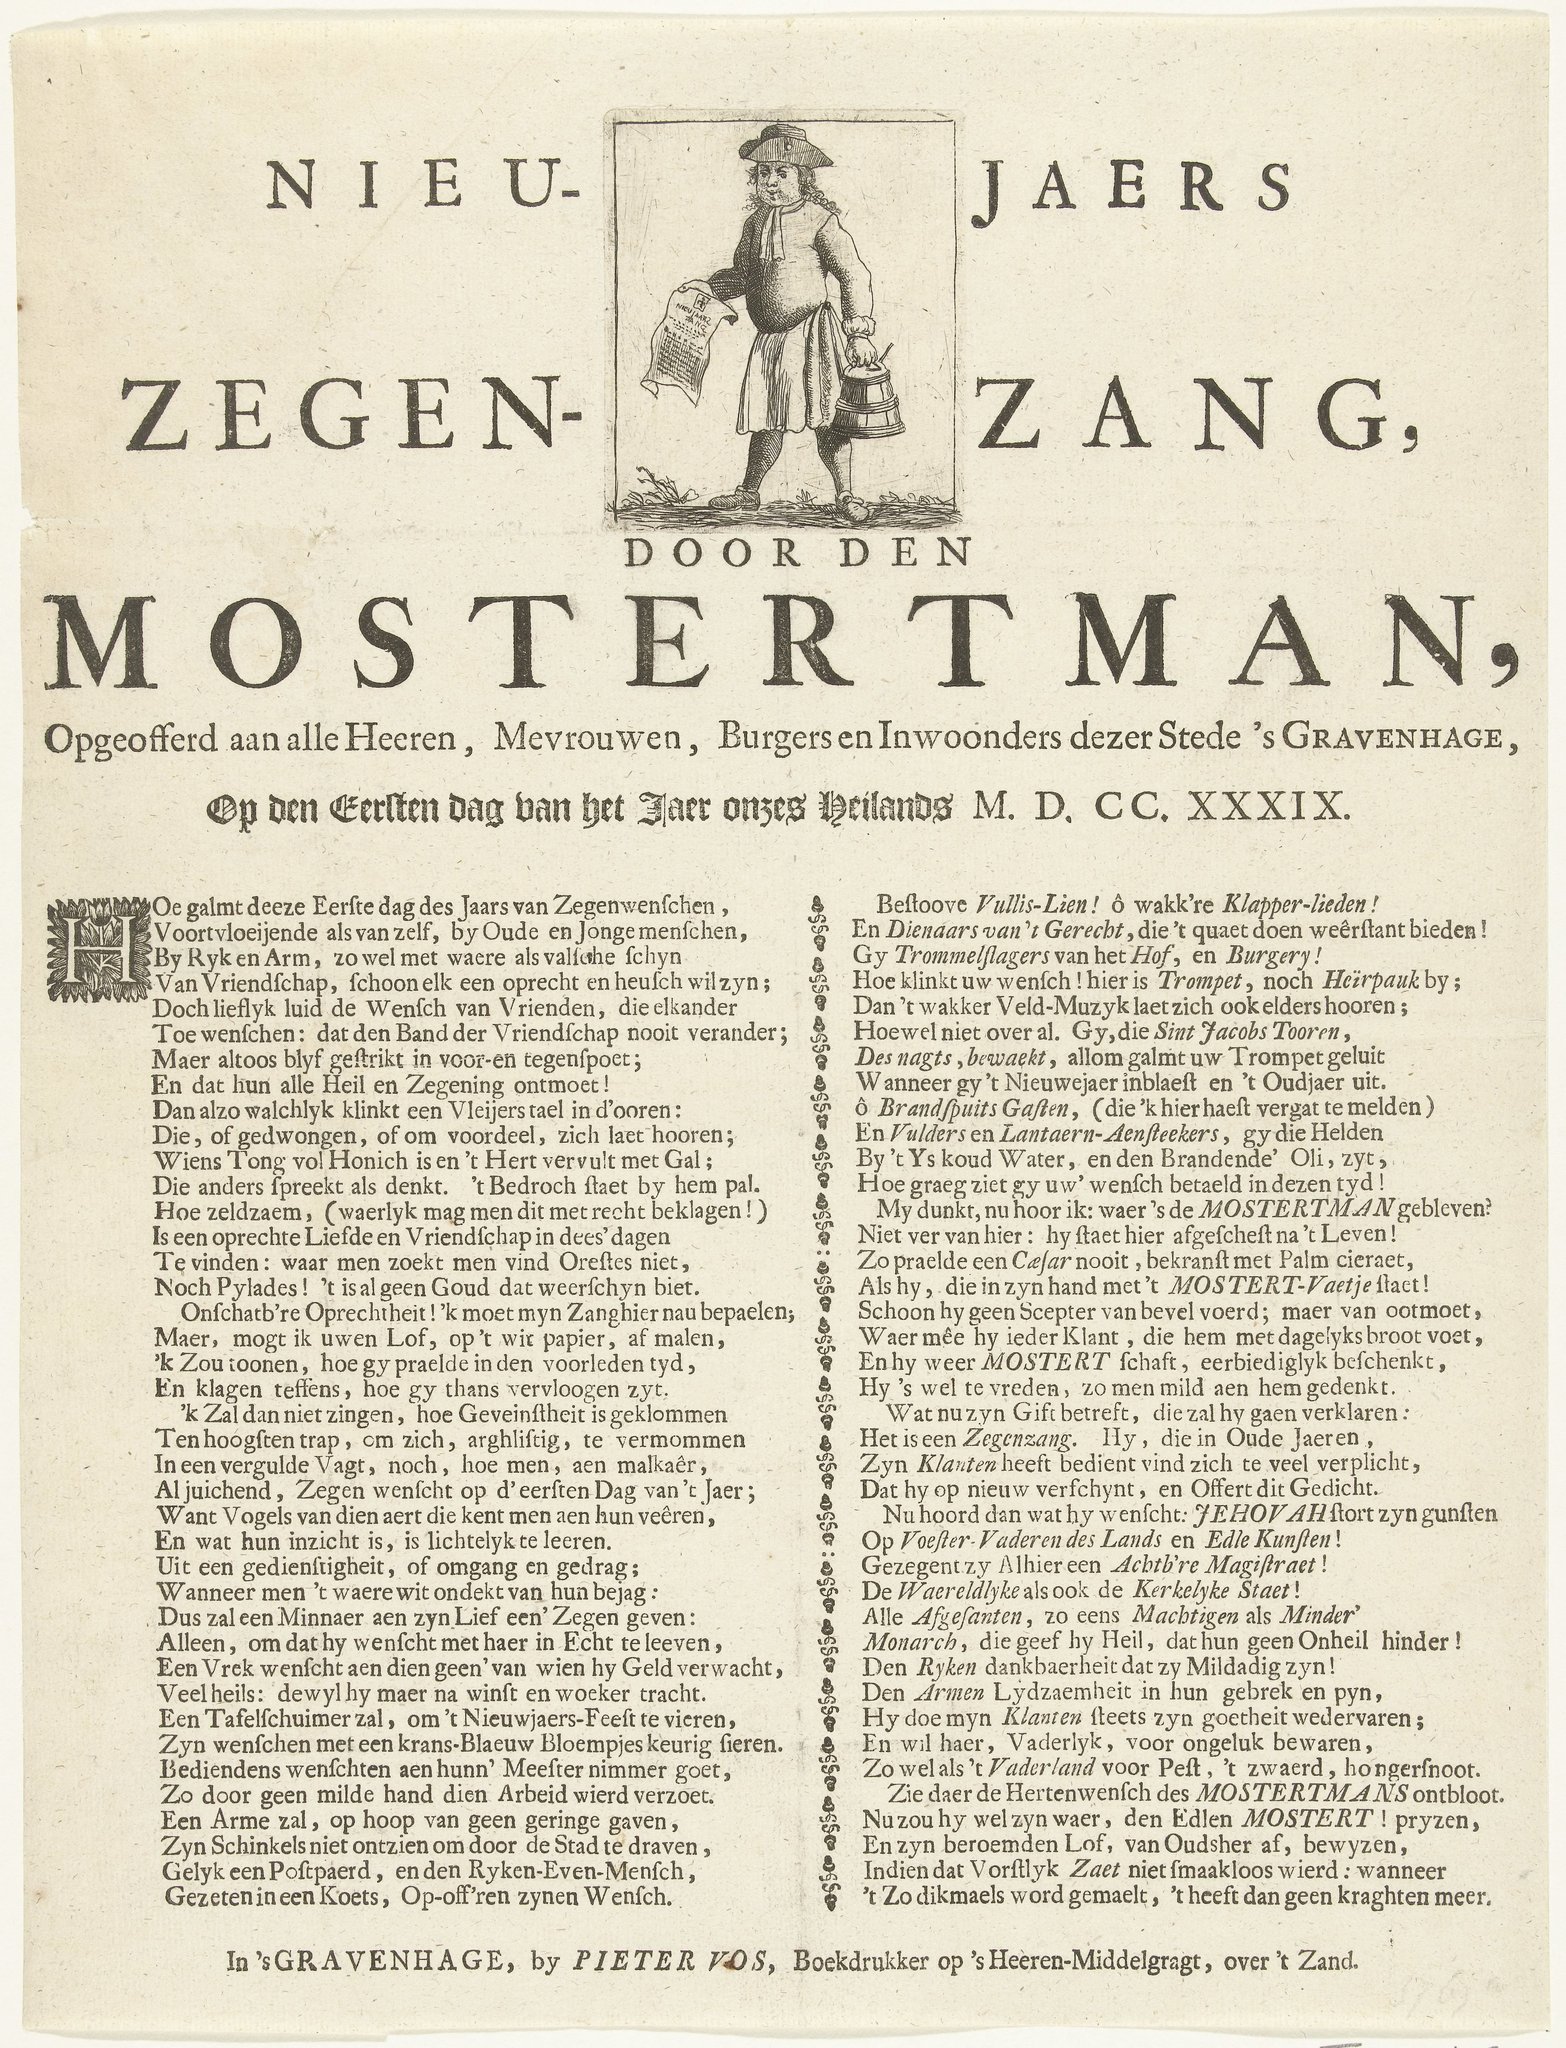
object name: new year card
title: Nieuwjaarswens van de Mosterdman te Den Haag, 1739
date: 1738-1739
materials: paper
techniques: engraving, etching, letterpress printing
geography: northern netherlands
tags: mustard (+ foodstuffs in other container, e.g.: barrel, can, cask, tin, etc.)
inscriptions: collector's mark: Lugt 2228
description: Nieuwjaarswens voor het jaar 1739 van de Mosterdman aan alle inwoners van Den Haag. Bovenaan een plaatje van een mosterdman met zijn vaatje en een nieuwjaarszang in de hand. Op het blad onder de plaat een vers in twee kolommen.